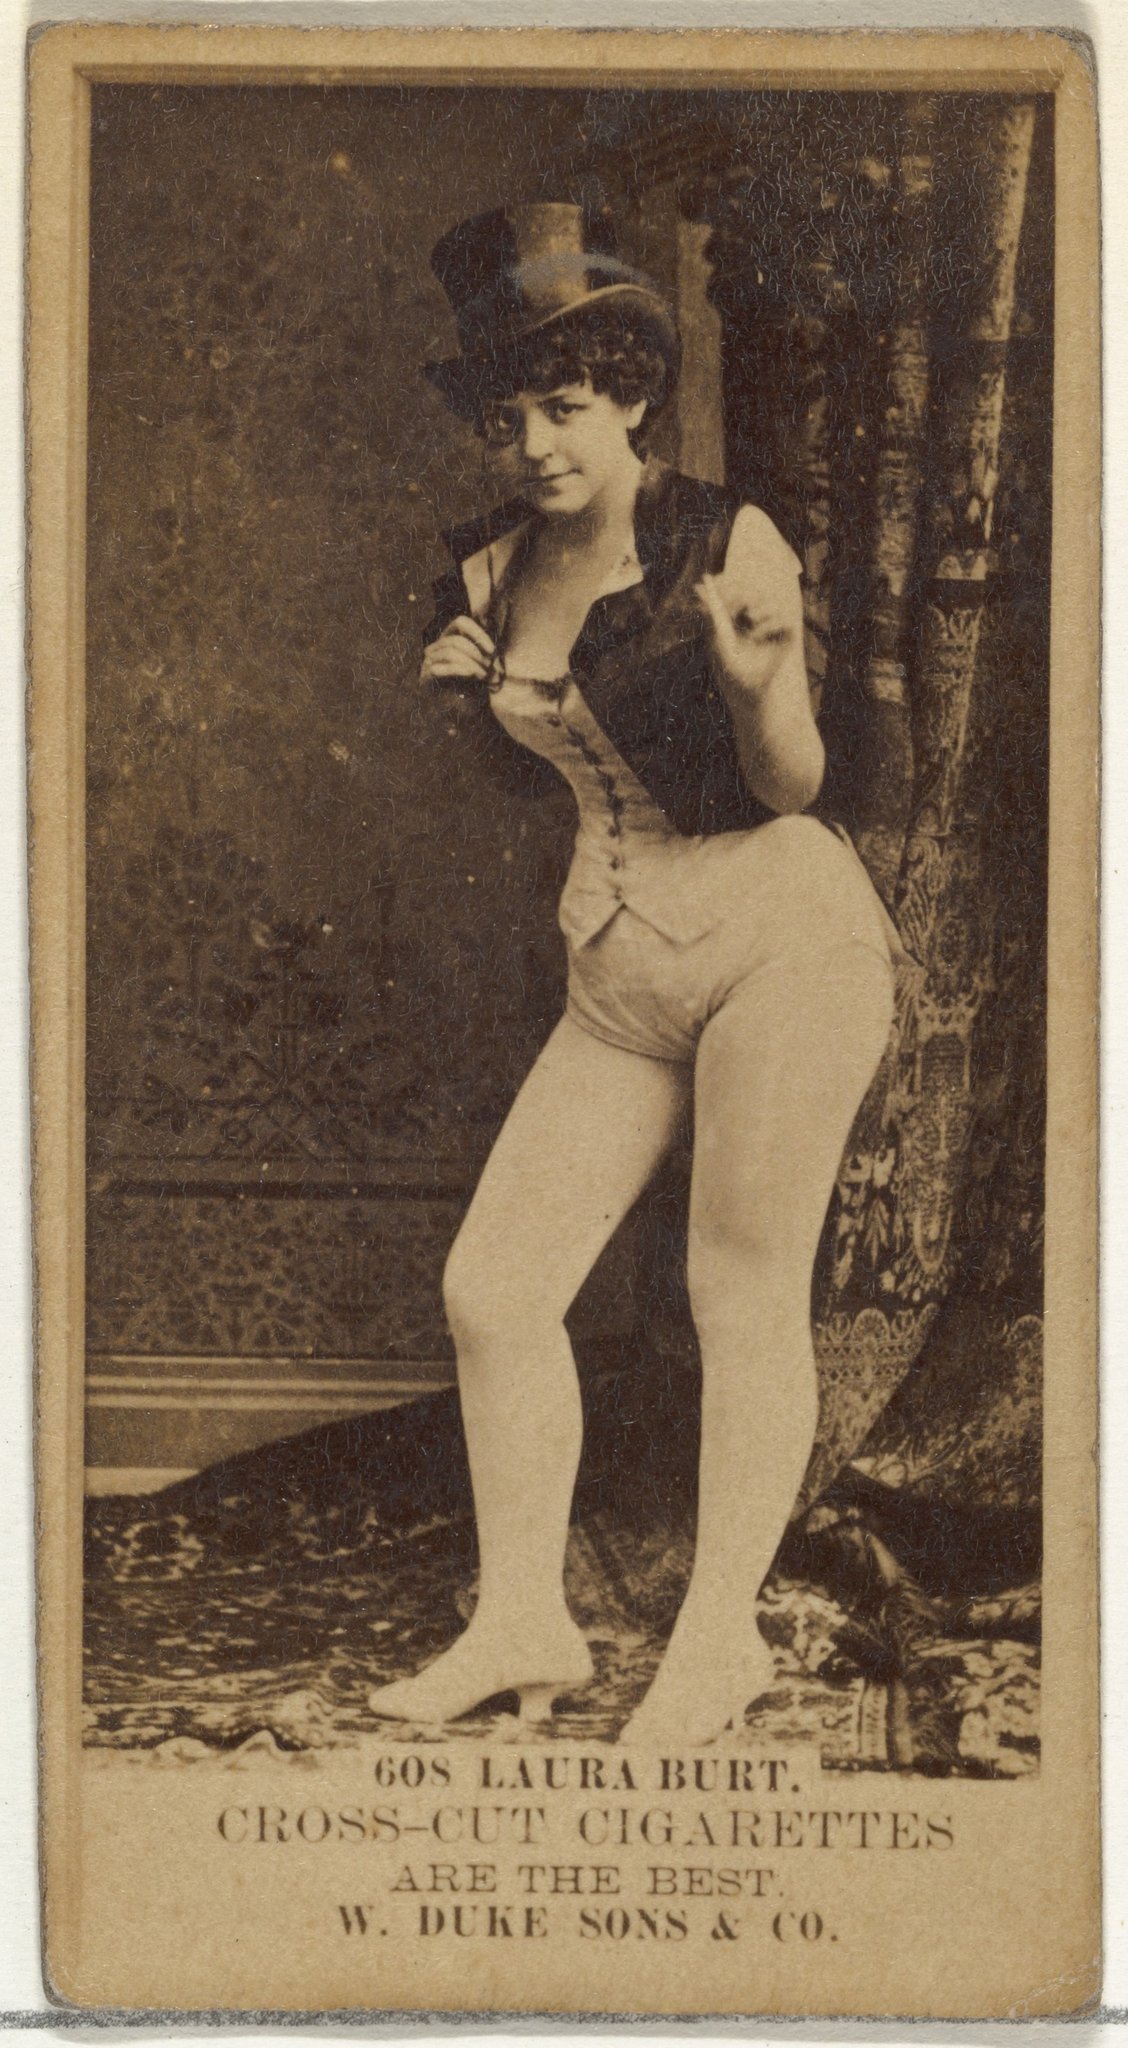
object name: photograph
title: Card Number 608, Laura Burt, from the Actors and Actresses series (N145-3) issued by Duke Sons & Co. to promote Cross Cut Cigarettes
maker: w. duke, sons & co.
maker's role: publisher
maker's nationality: american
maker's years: 1870-1920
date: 1880-1889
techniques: albumen silver print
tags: portraits,women,actresses